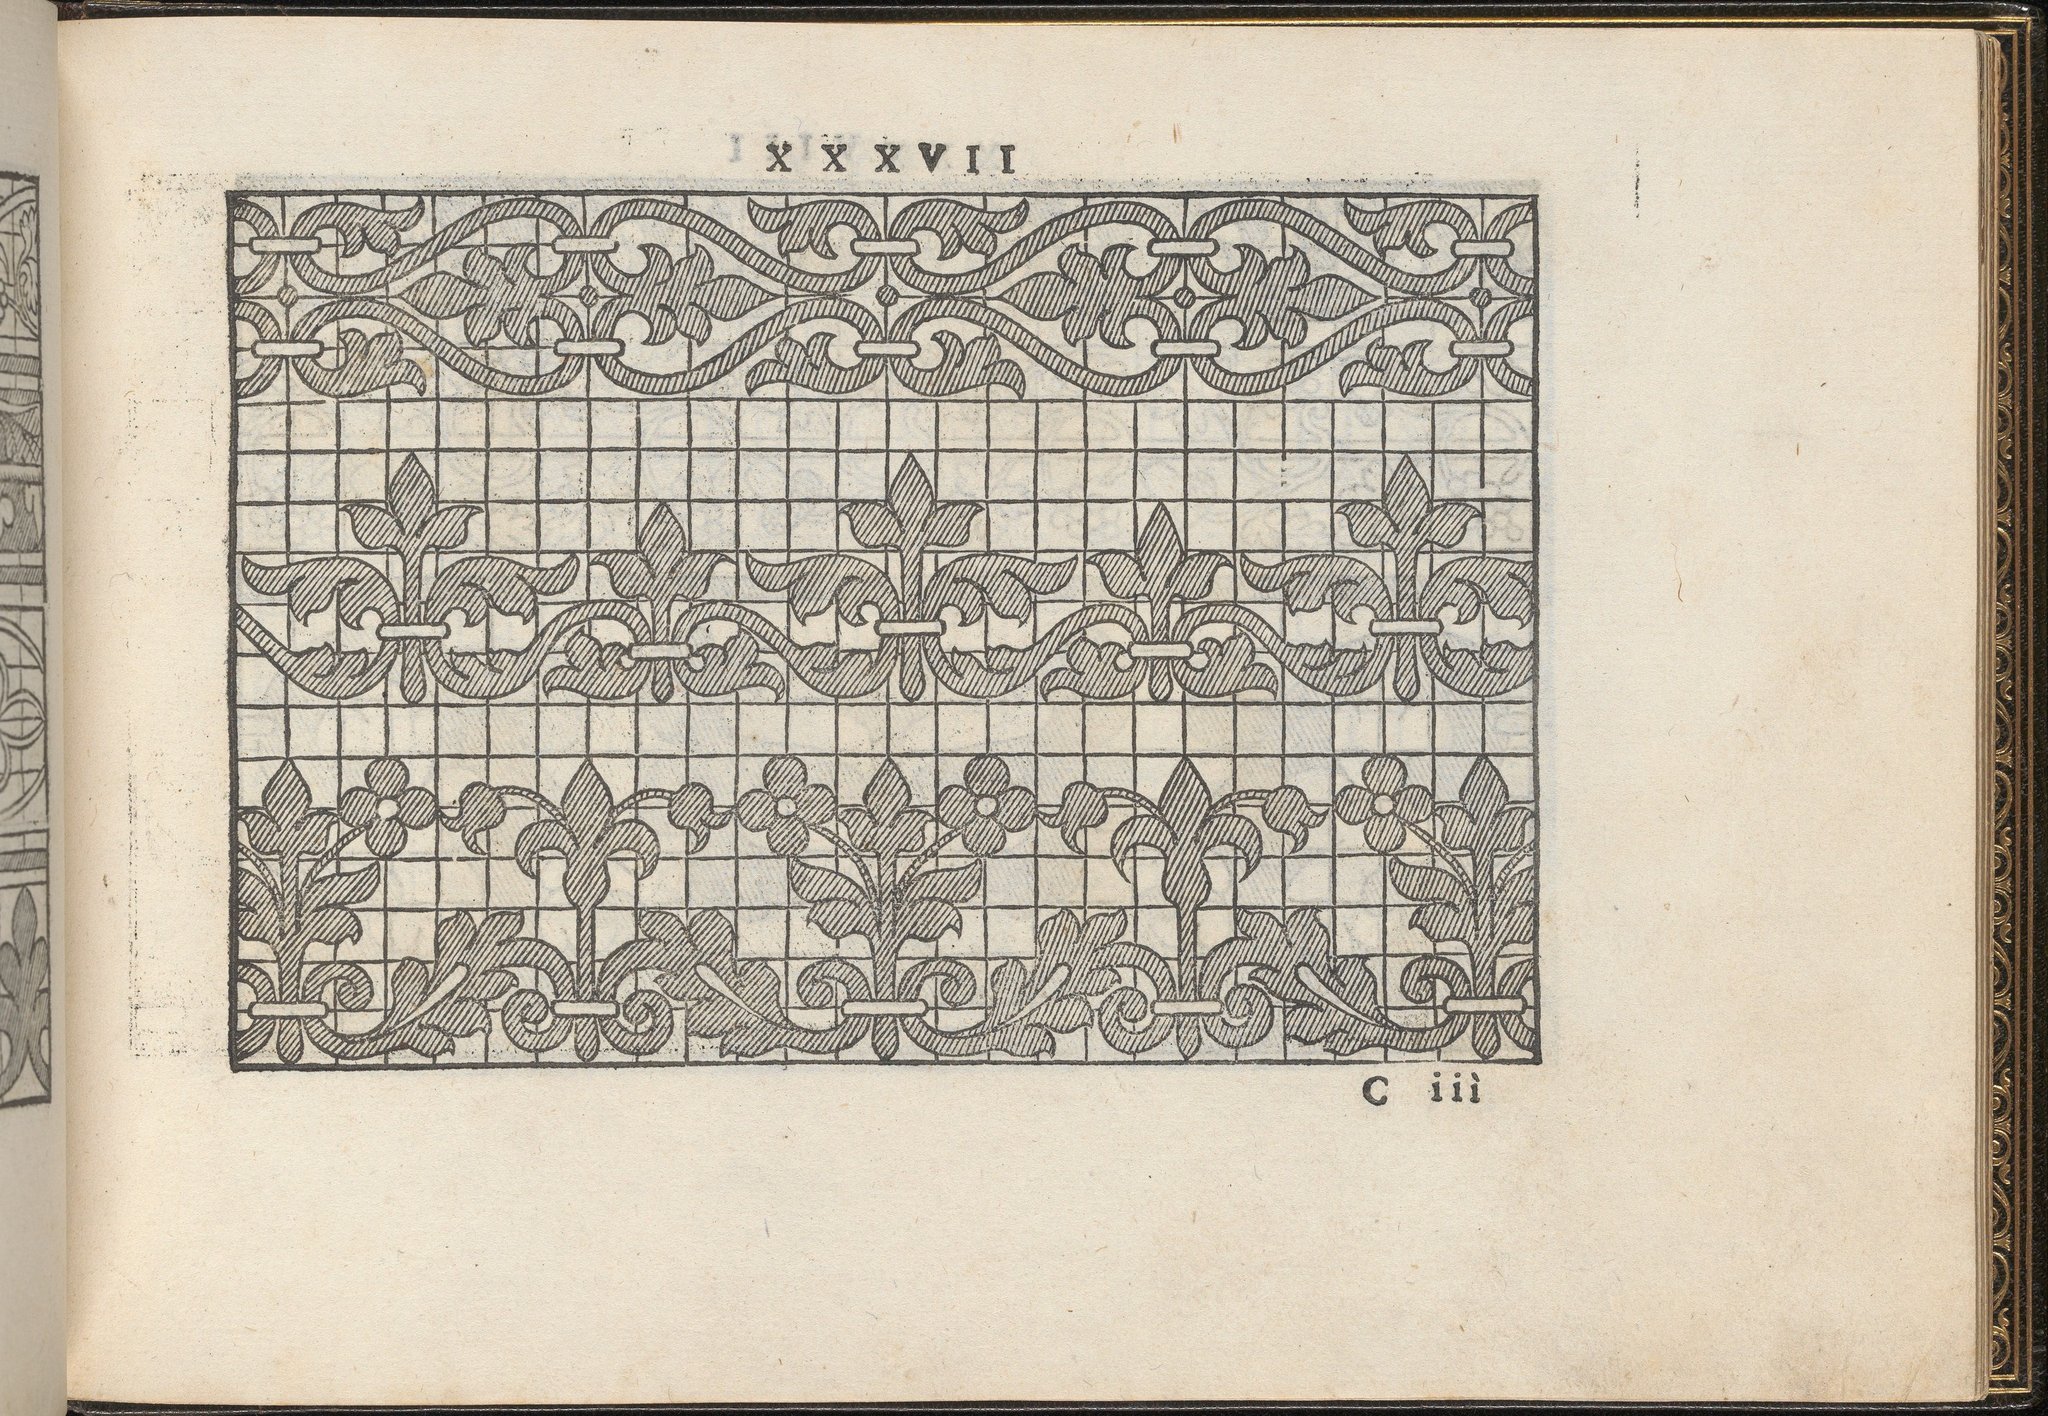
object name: book print ornament architecture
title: La Vera Perfettione del Disegno di varie sorti di recami, page 19 (recto)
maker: giovanni ostaus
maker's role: publisher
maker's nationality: italian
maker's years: 1507-1607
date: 1567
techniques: woodcut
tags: ornament